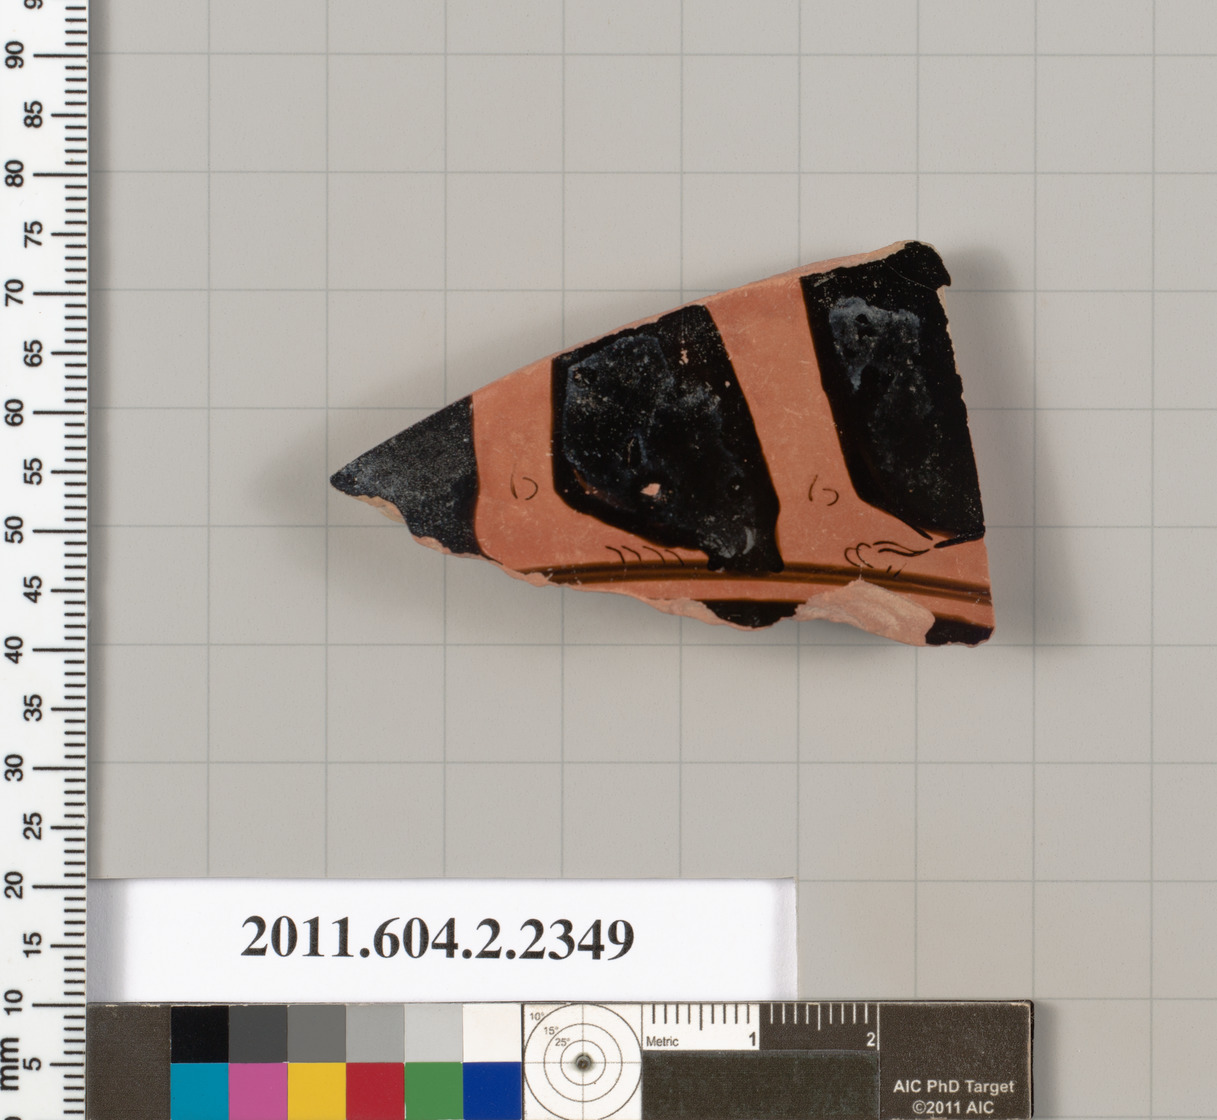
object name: krater fragment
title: Terracotta fragment of a krater (bowl for mixing wine and water)?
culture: greek, attic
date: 475-451 BCE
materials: terracotta